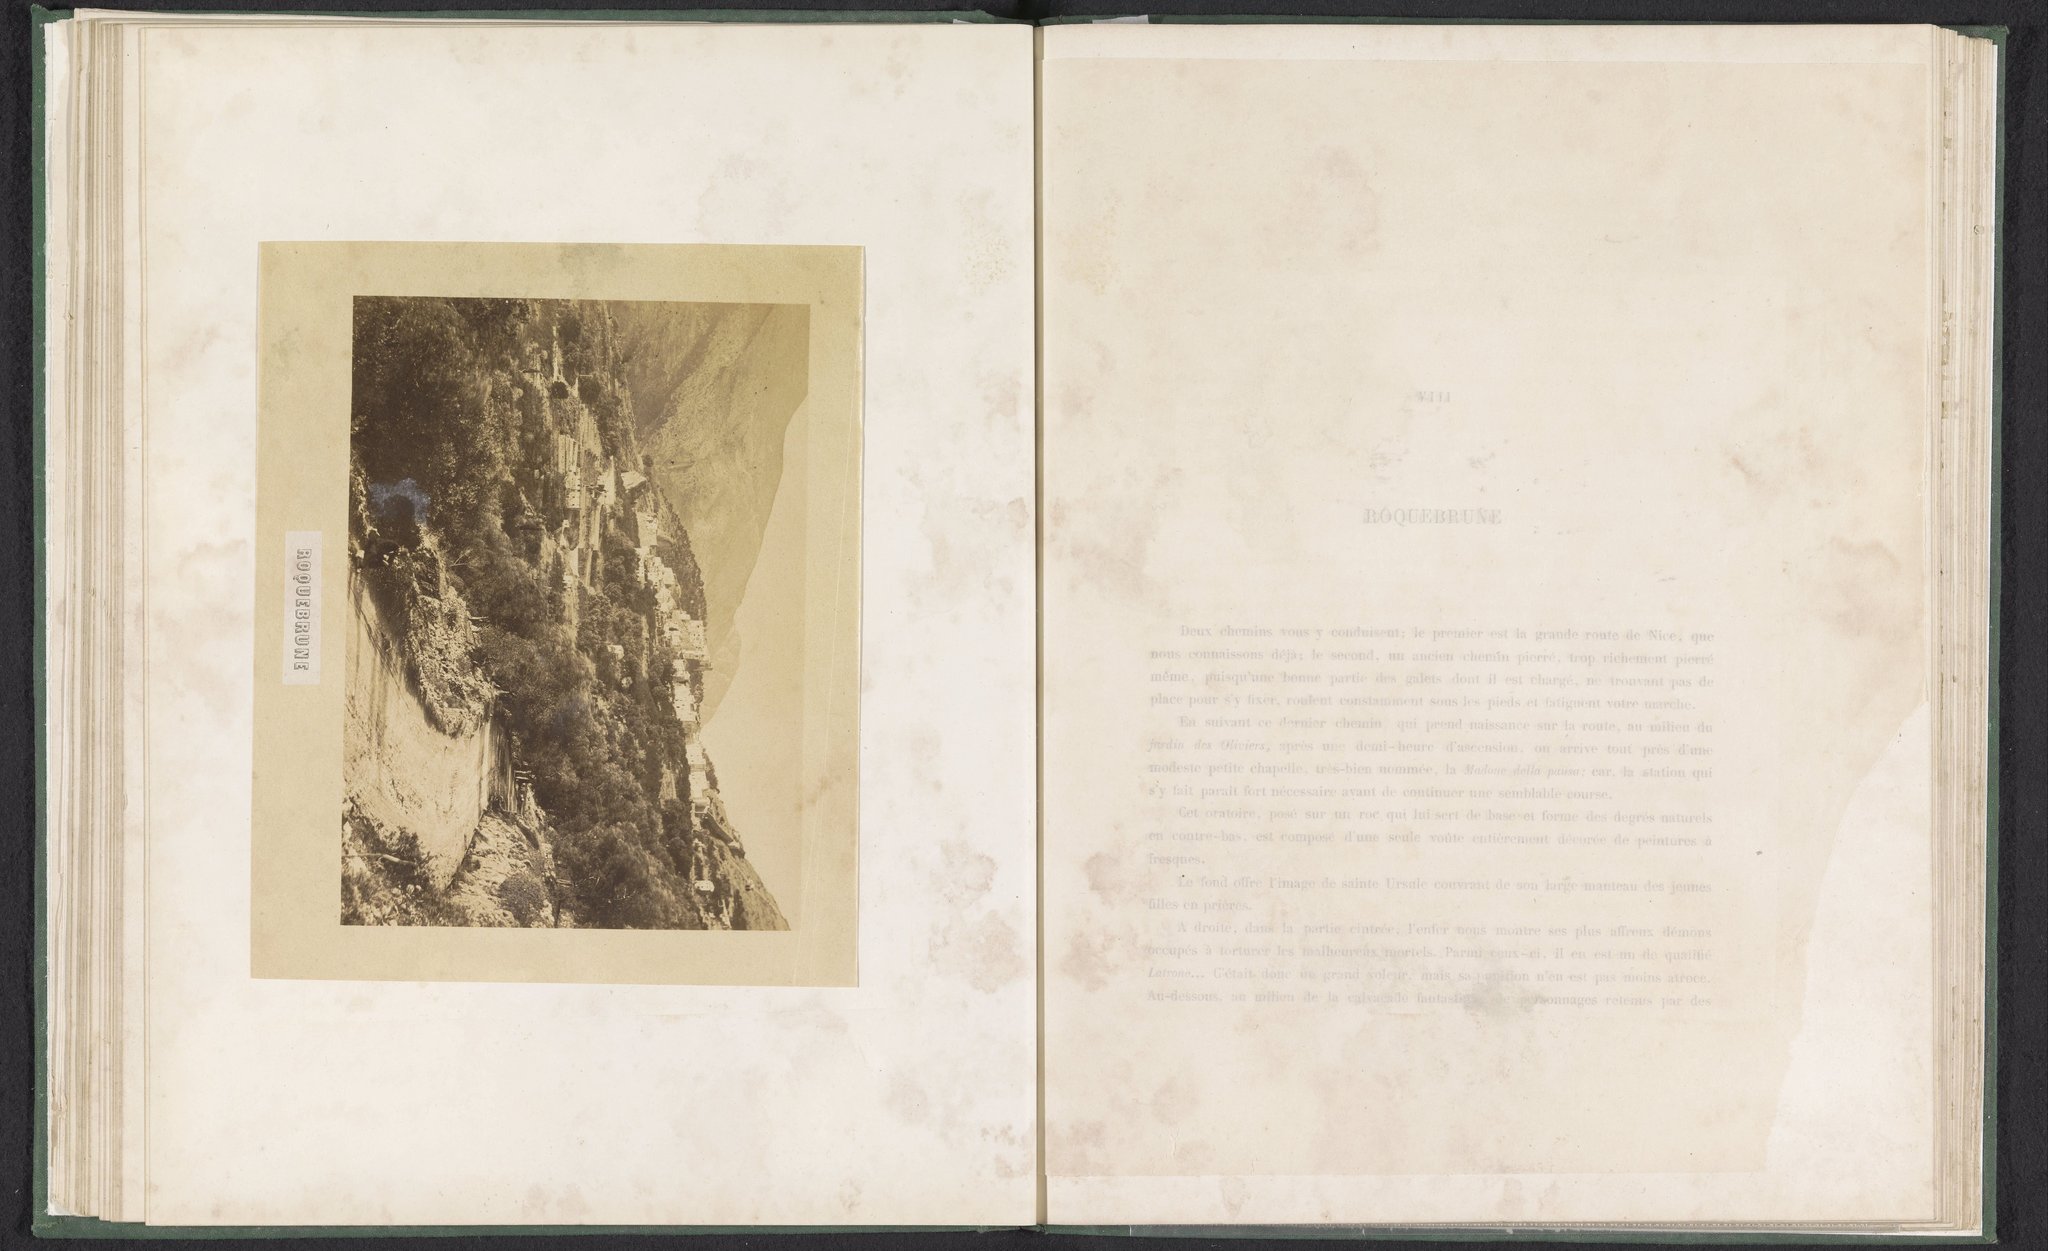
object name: photograph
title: Roquebrune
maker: louis-alphonse davanne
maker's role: fotograaf, scheikundige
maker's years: 1824-1912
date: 1852-1862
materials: photographic support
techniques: albumen print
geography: roquebrune-cap-martin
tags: city-view in general; 'veduta'